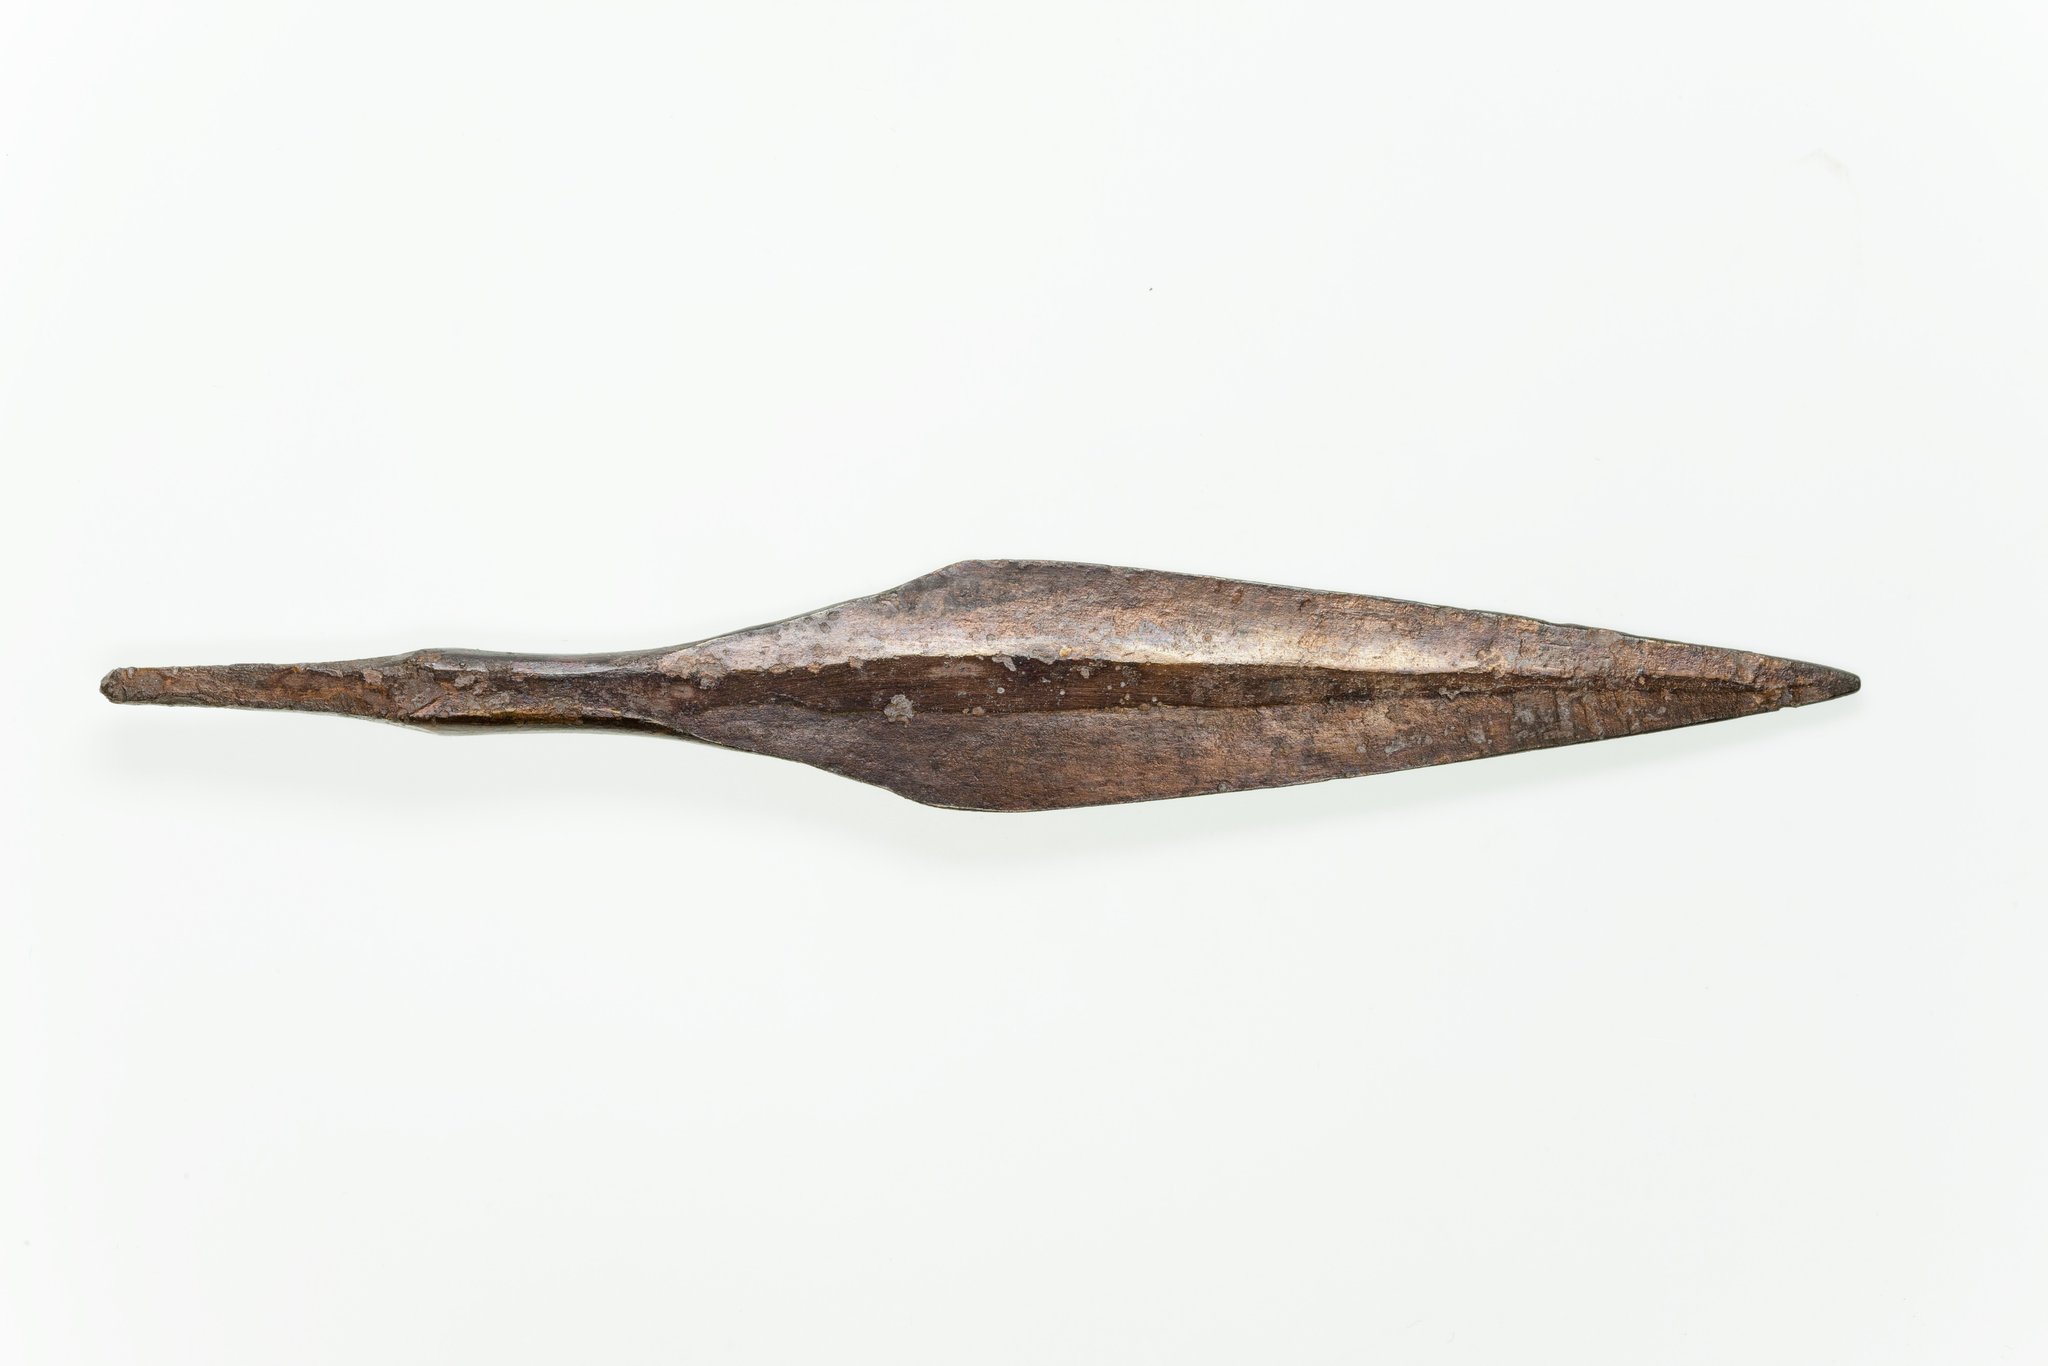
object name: arrow point, neferkhawet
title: Arrow or Javelin Point of Neferkhawet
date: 1504-1447 BCE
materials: bronze, copper alloy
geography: egypt